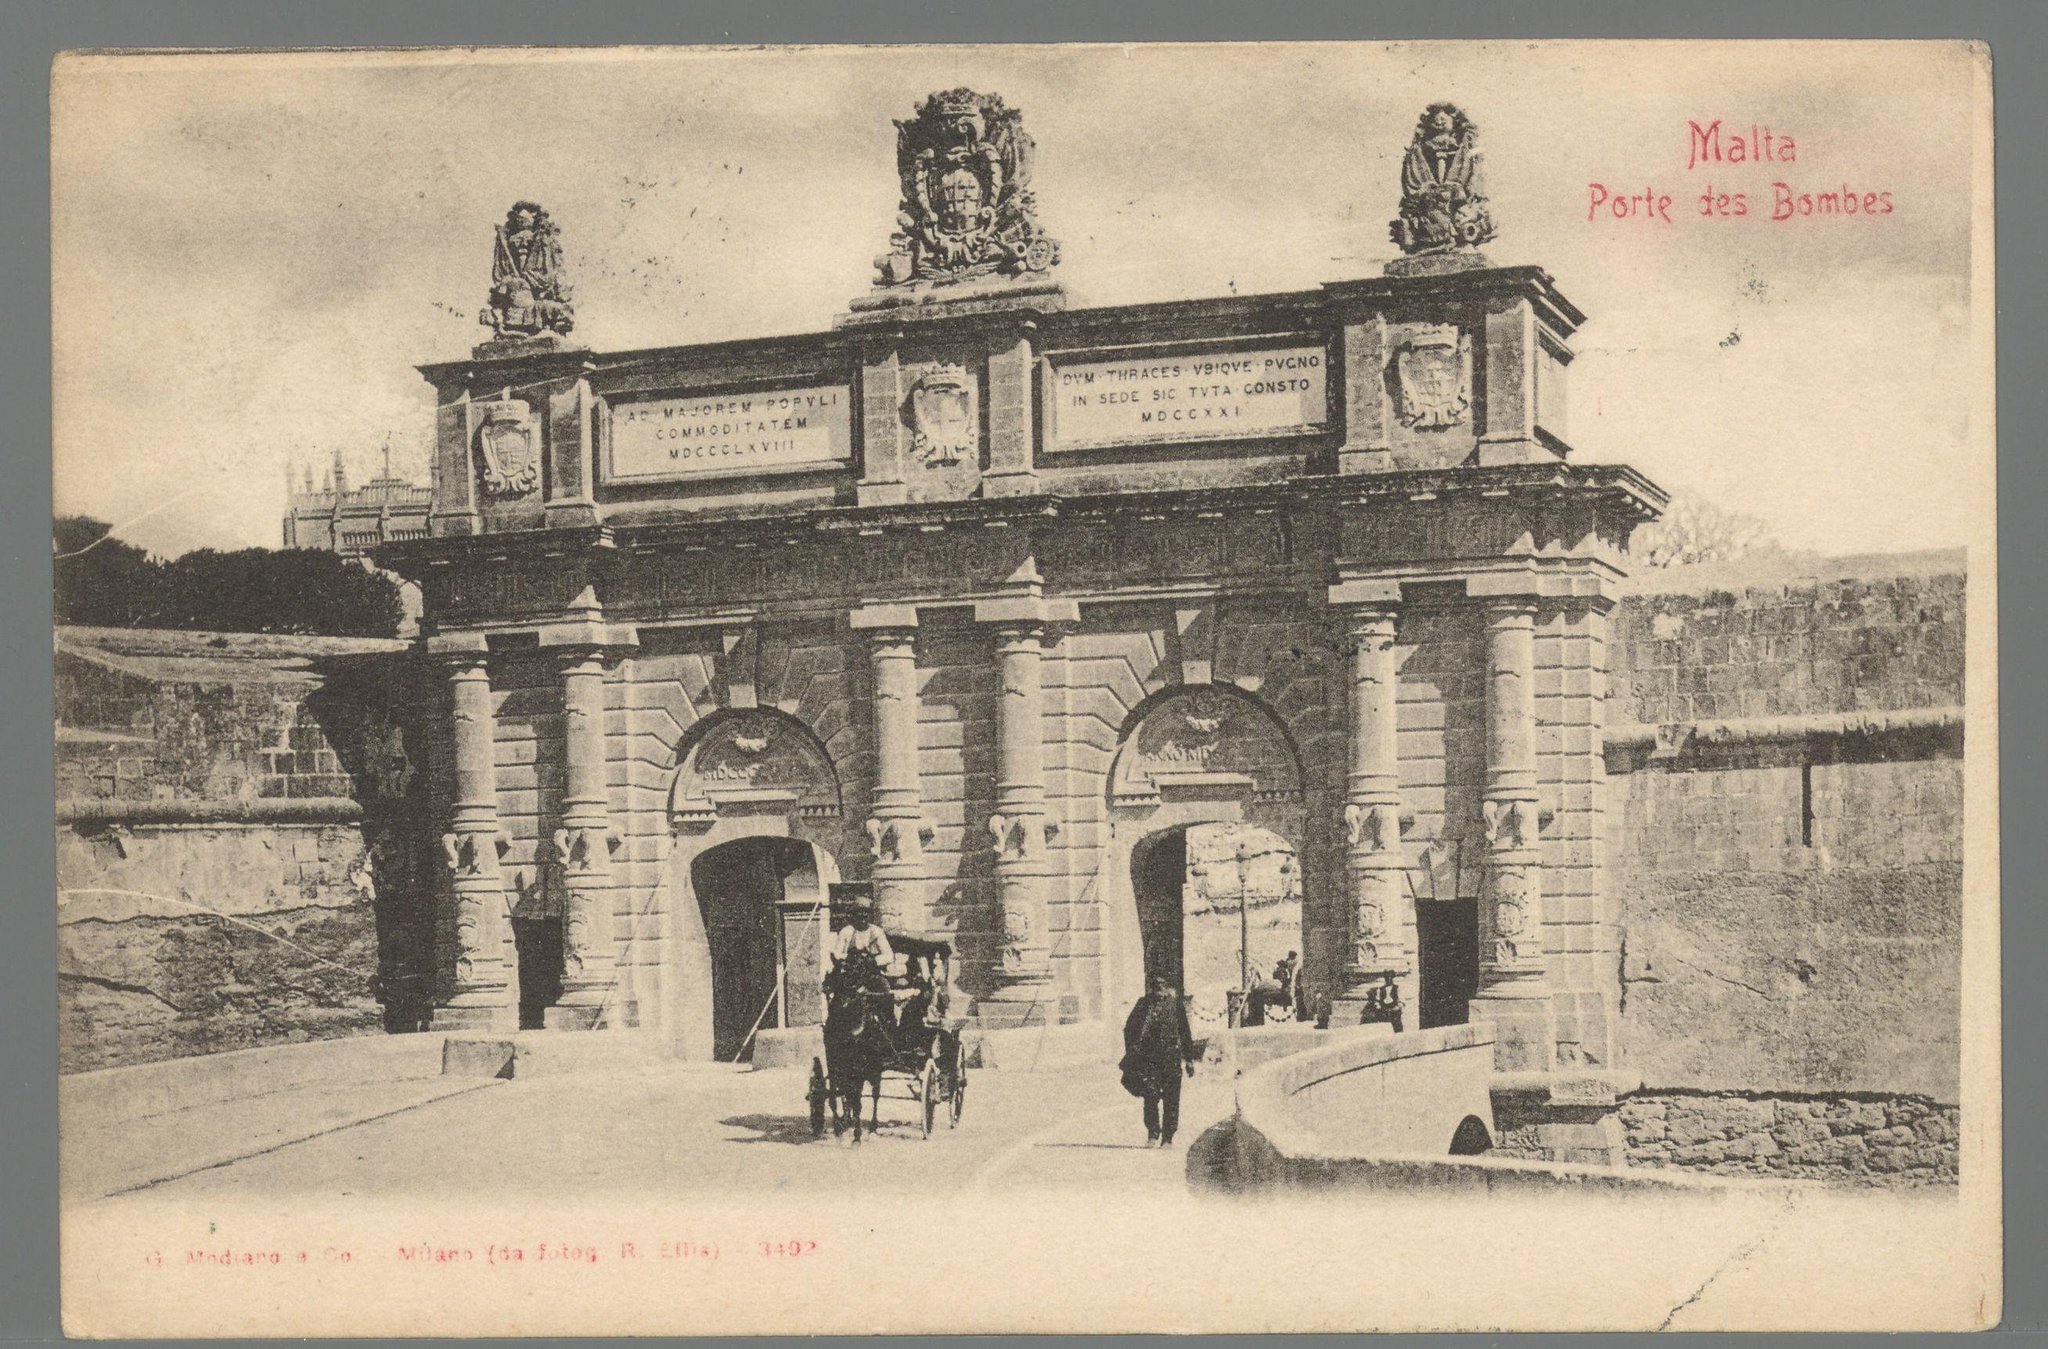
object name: photomechanical print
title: Malta. Porte des Bombes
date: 1890-1903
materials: cardboard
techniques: photograph, writing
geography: milan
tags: city-gate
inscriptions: poststempel, verso, gestempeld